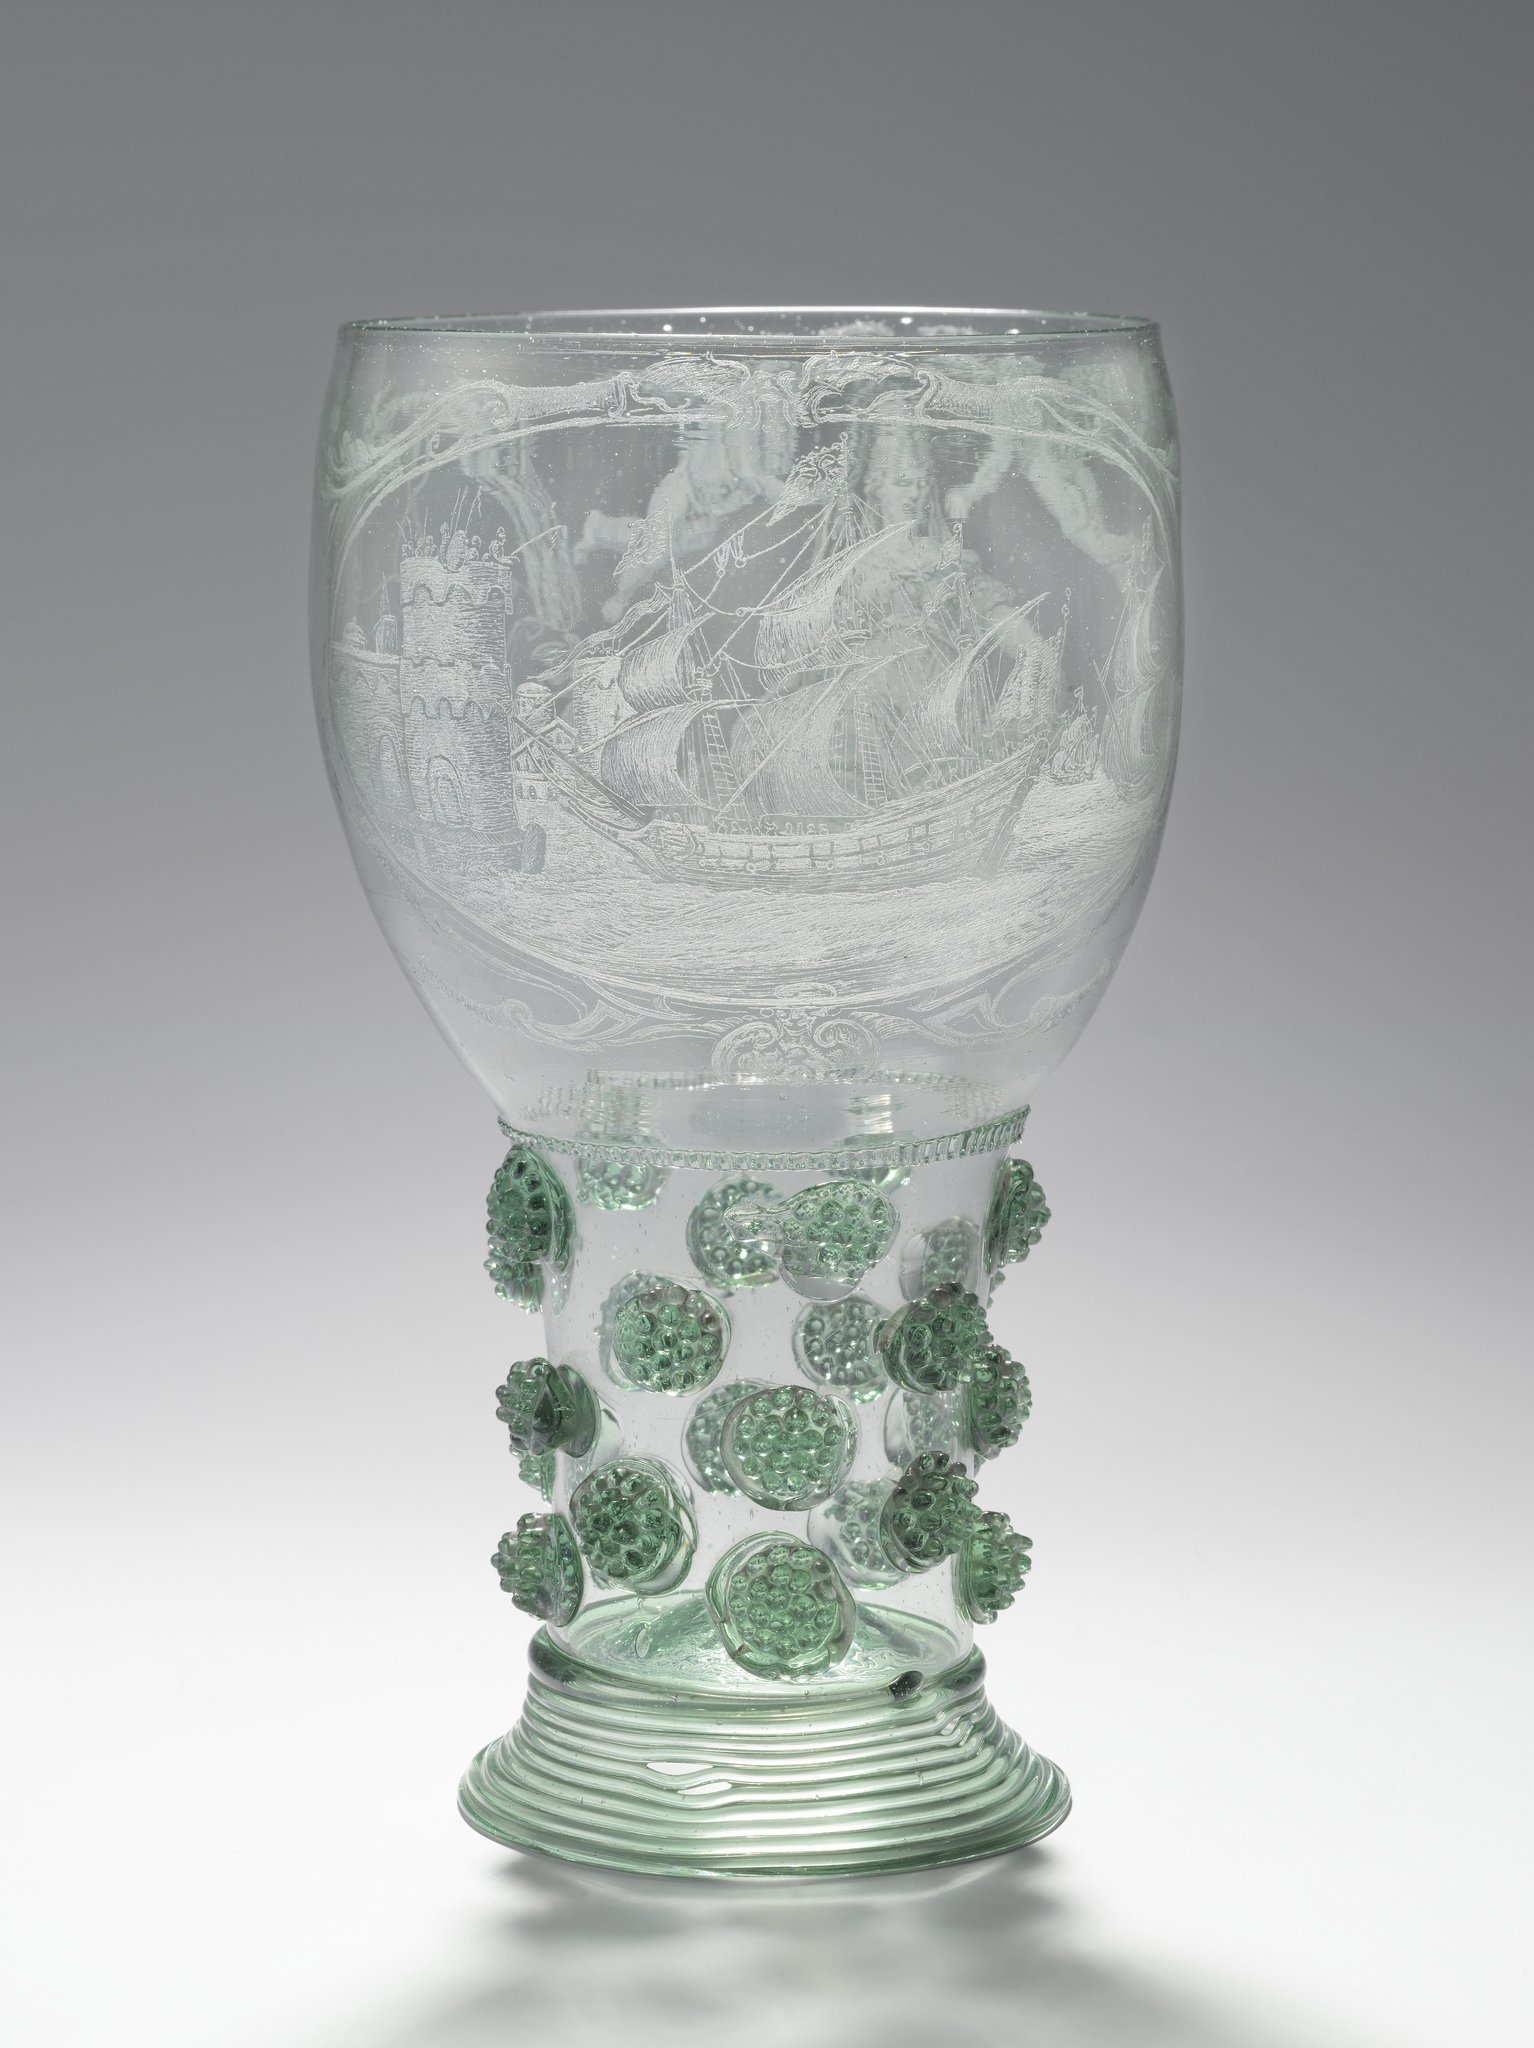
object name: roemer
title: Roemer met de inname van de stad Damiate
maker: meester cm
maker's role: glasgraveur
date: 1644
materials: glass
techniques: diamond point engraving, glassblowing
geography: northern netherlands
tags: damiate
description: Konische, uit een draad gesponnen voet. Ingestoken bodem. De stam, die bezet is met vijf rijen braamnoppen, is als één geheel geblazen met de gebogen kelk. Een geribde draad geeft de overgang van de stam naar de kelk aan.In een ovaal, uit voluten opgebouwde medaillon is de inneming van de stad Damiate gegraveerd, voorgesteld door drie schepen voor de stadmuren met een toren, waarop krijgsvolk staat. Ter weerskanten van de cartouche hangt een klok aan een krullende bladrank. Op de bladrank zit een schildpad. Op de keerzijde is de Stedemaagd van Haarlem afgebeeld. Aan haar rechter hand hangt een wapenschild met het nieuwe wapen van Haarlem, een staand zwaard met ter weerskanten van het lammet twee zespuntige sterren. Ze zit op een leeuw, waarvan de kop links van haar te voorschijn komt. In haar linker hand houdt zij een palmtak. Twee zwevende putti houden een lauwerkrans boven haar hoofd. Tussen de Stedemaagd en de inneming van Damiate is een wapenschild met het oude wapen van Haarlem, een dorre, ontwortelde boom, afgebeeld. Het wapen hangt in een ovaal medaillon van gestileerde bladbundels. Links onder de Stedemaagd staat het monogram en het jaartal 'JCM 1644'.